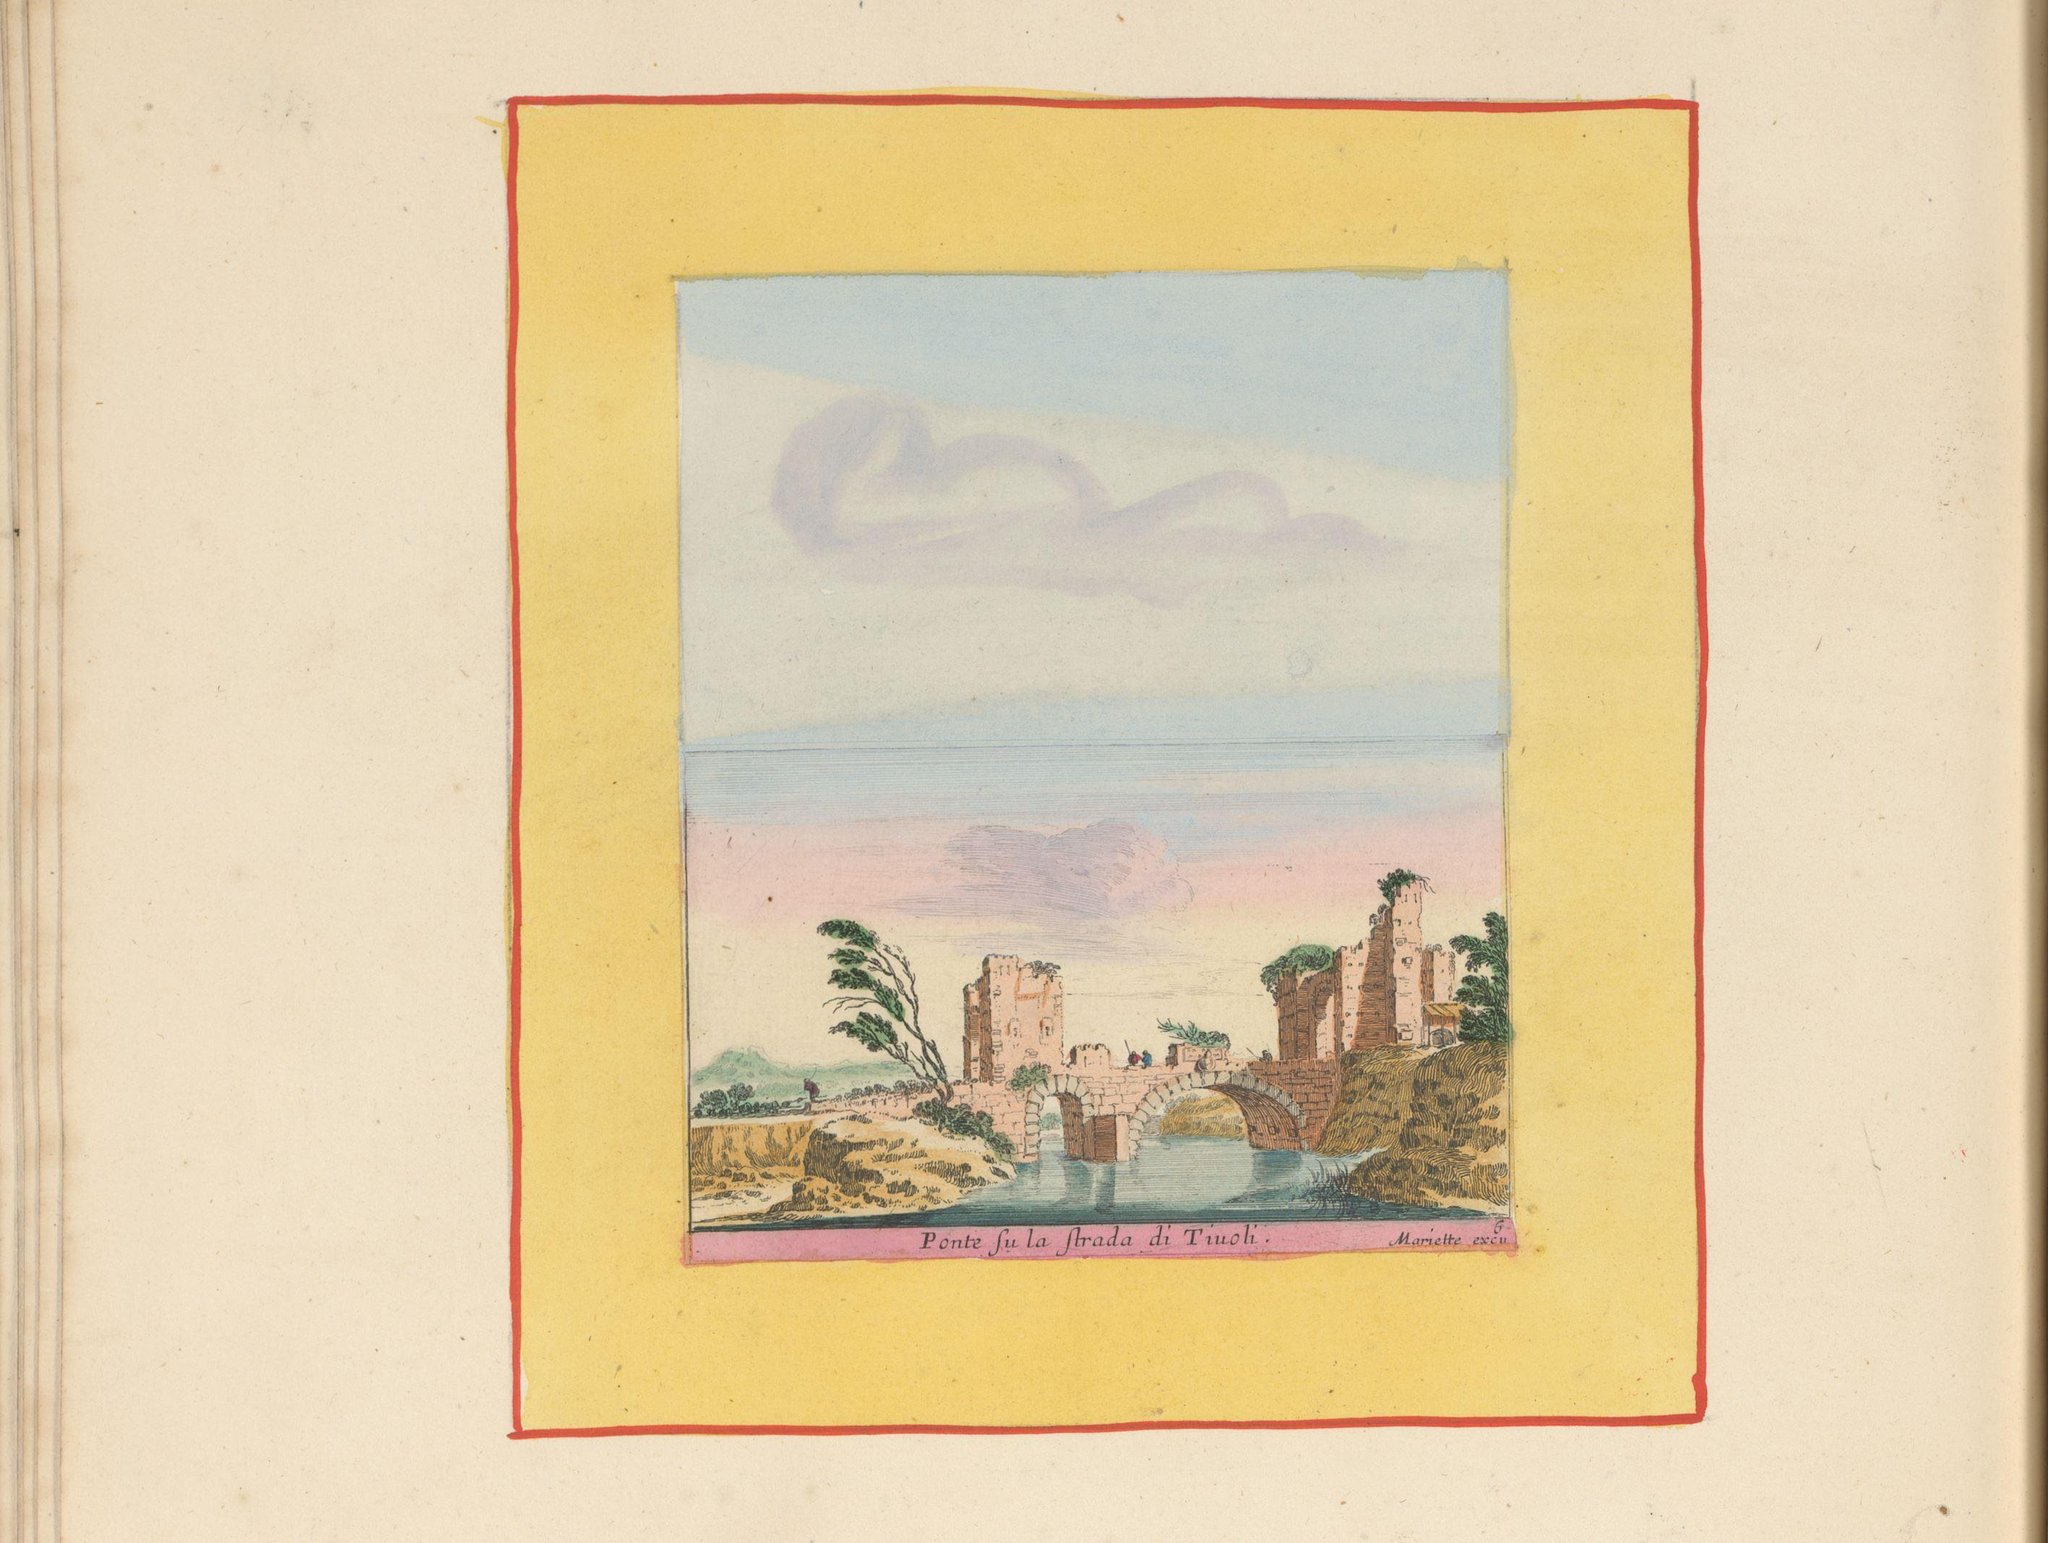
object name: album leaf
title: Ponte su la strada di Tivoli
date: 1632-1657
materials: paper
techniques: colour, etching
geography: the hague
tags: city-view, and landscape with man-made constructions, bridge, tivoli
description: Landschap met een brug waarover een straat loopt richting Tivoli. Prent maakt deel uit van een album.